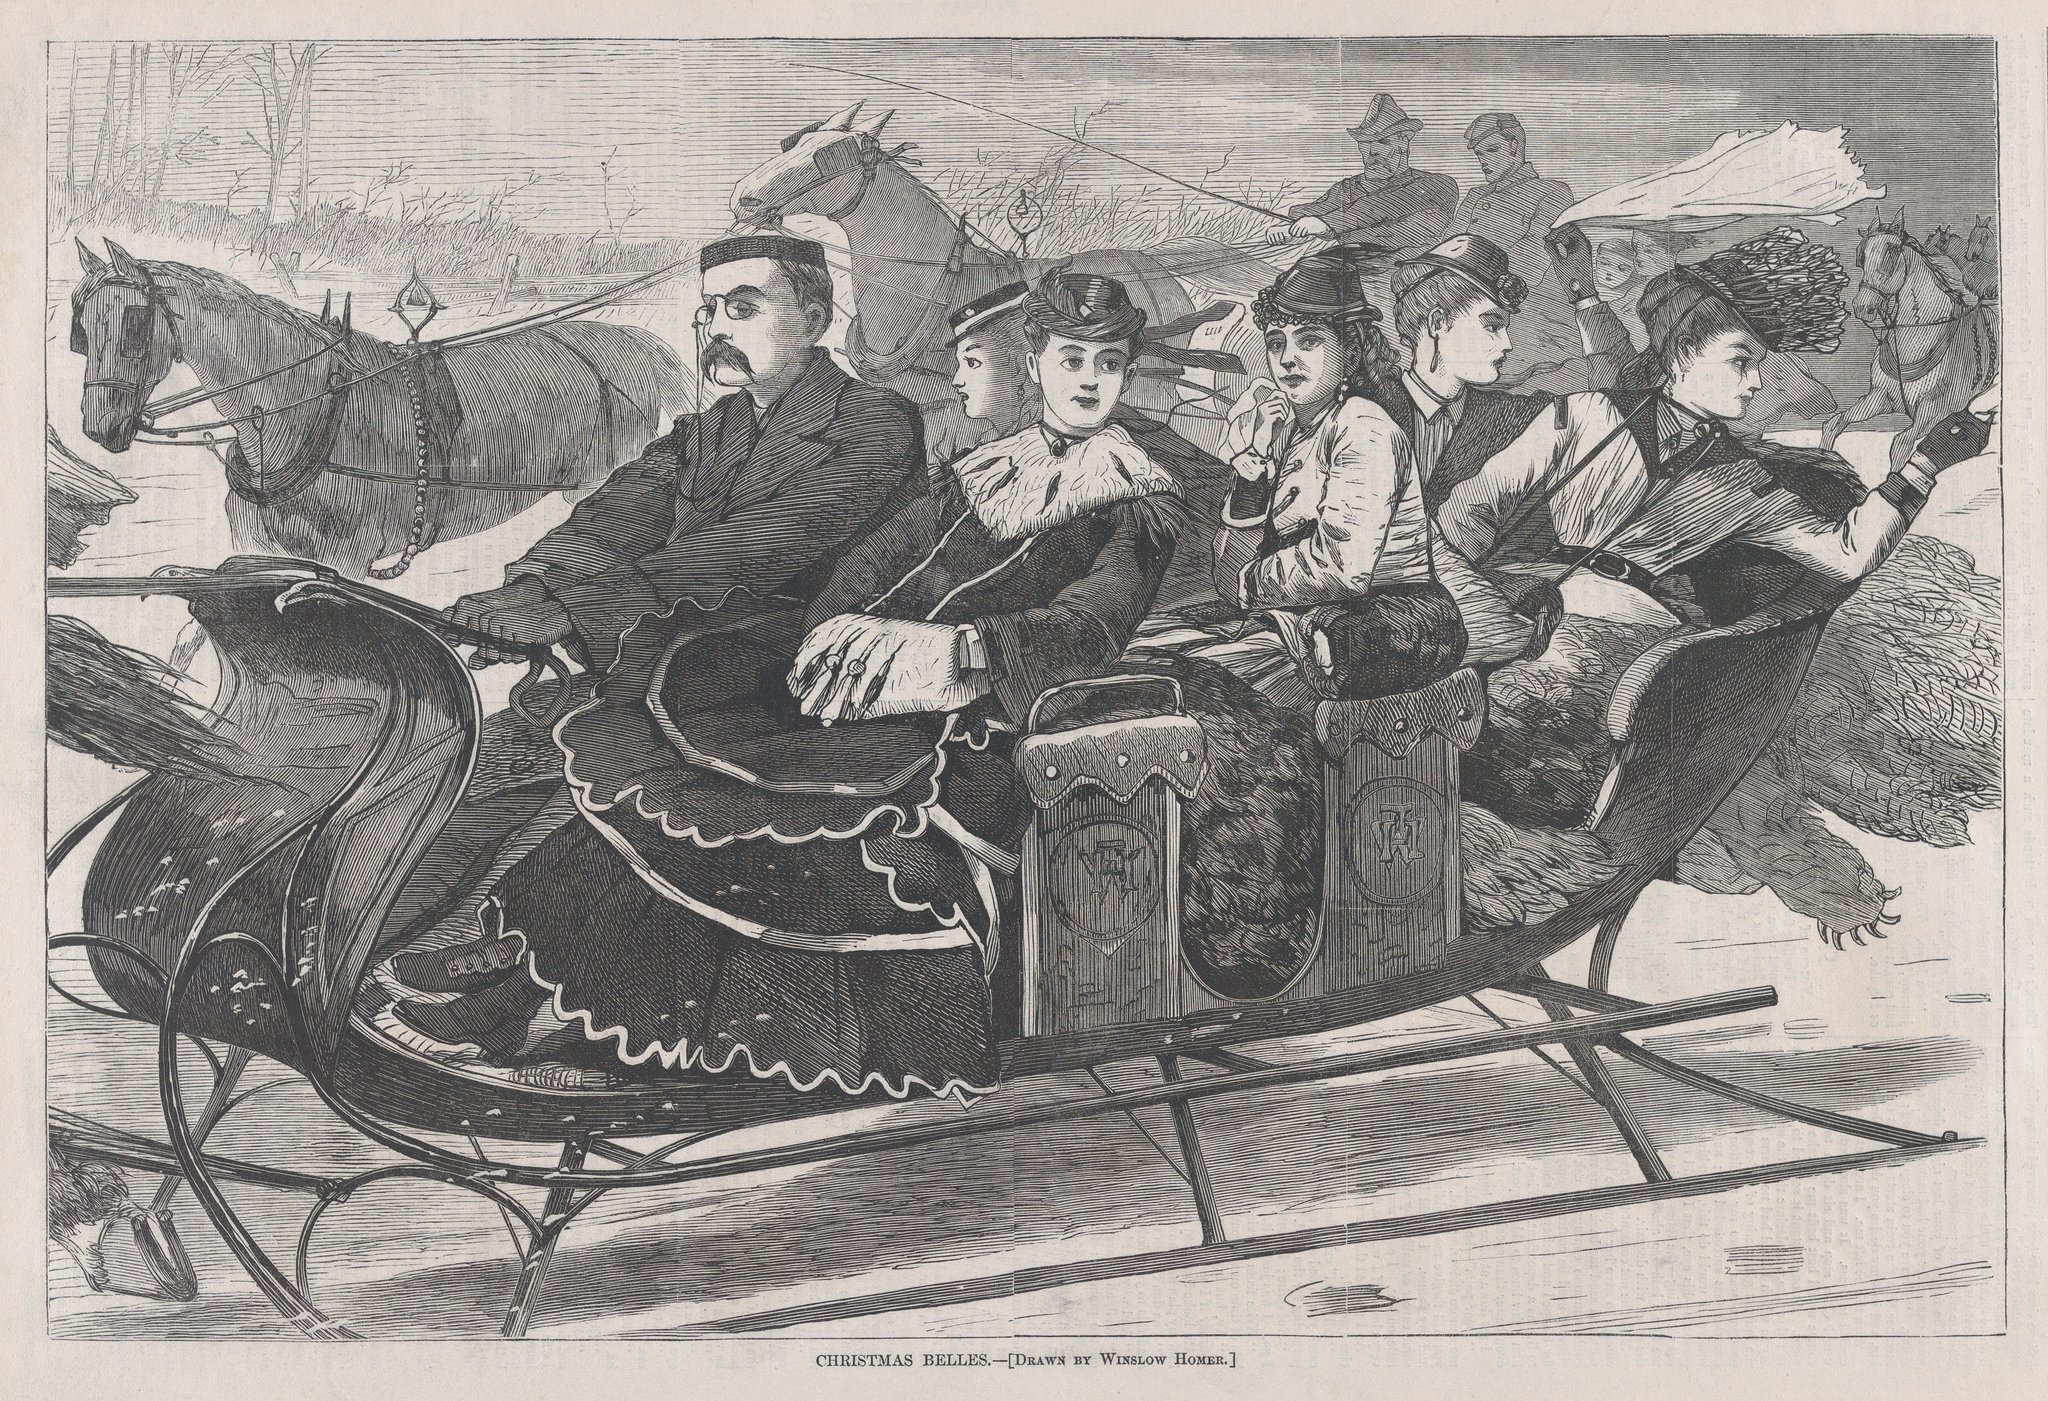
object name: print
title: Christmas Belles (from "Harper's Weekly," Vol. XIII)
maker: winslow homer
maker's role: artist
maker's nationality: american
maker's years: 1836-1910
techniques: engraving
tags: men,women,sledging,horses,sleighs